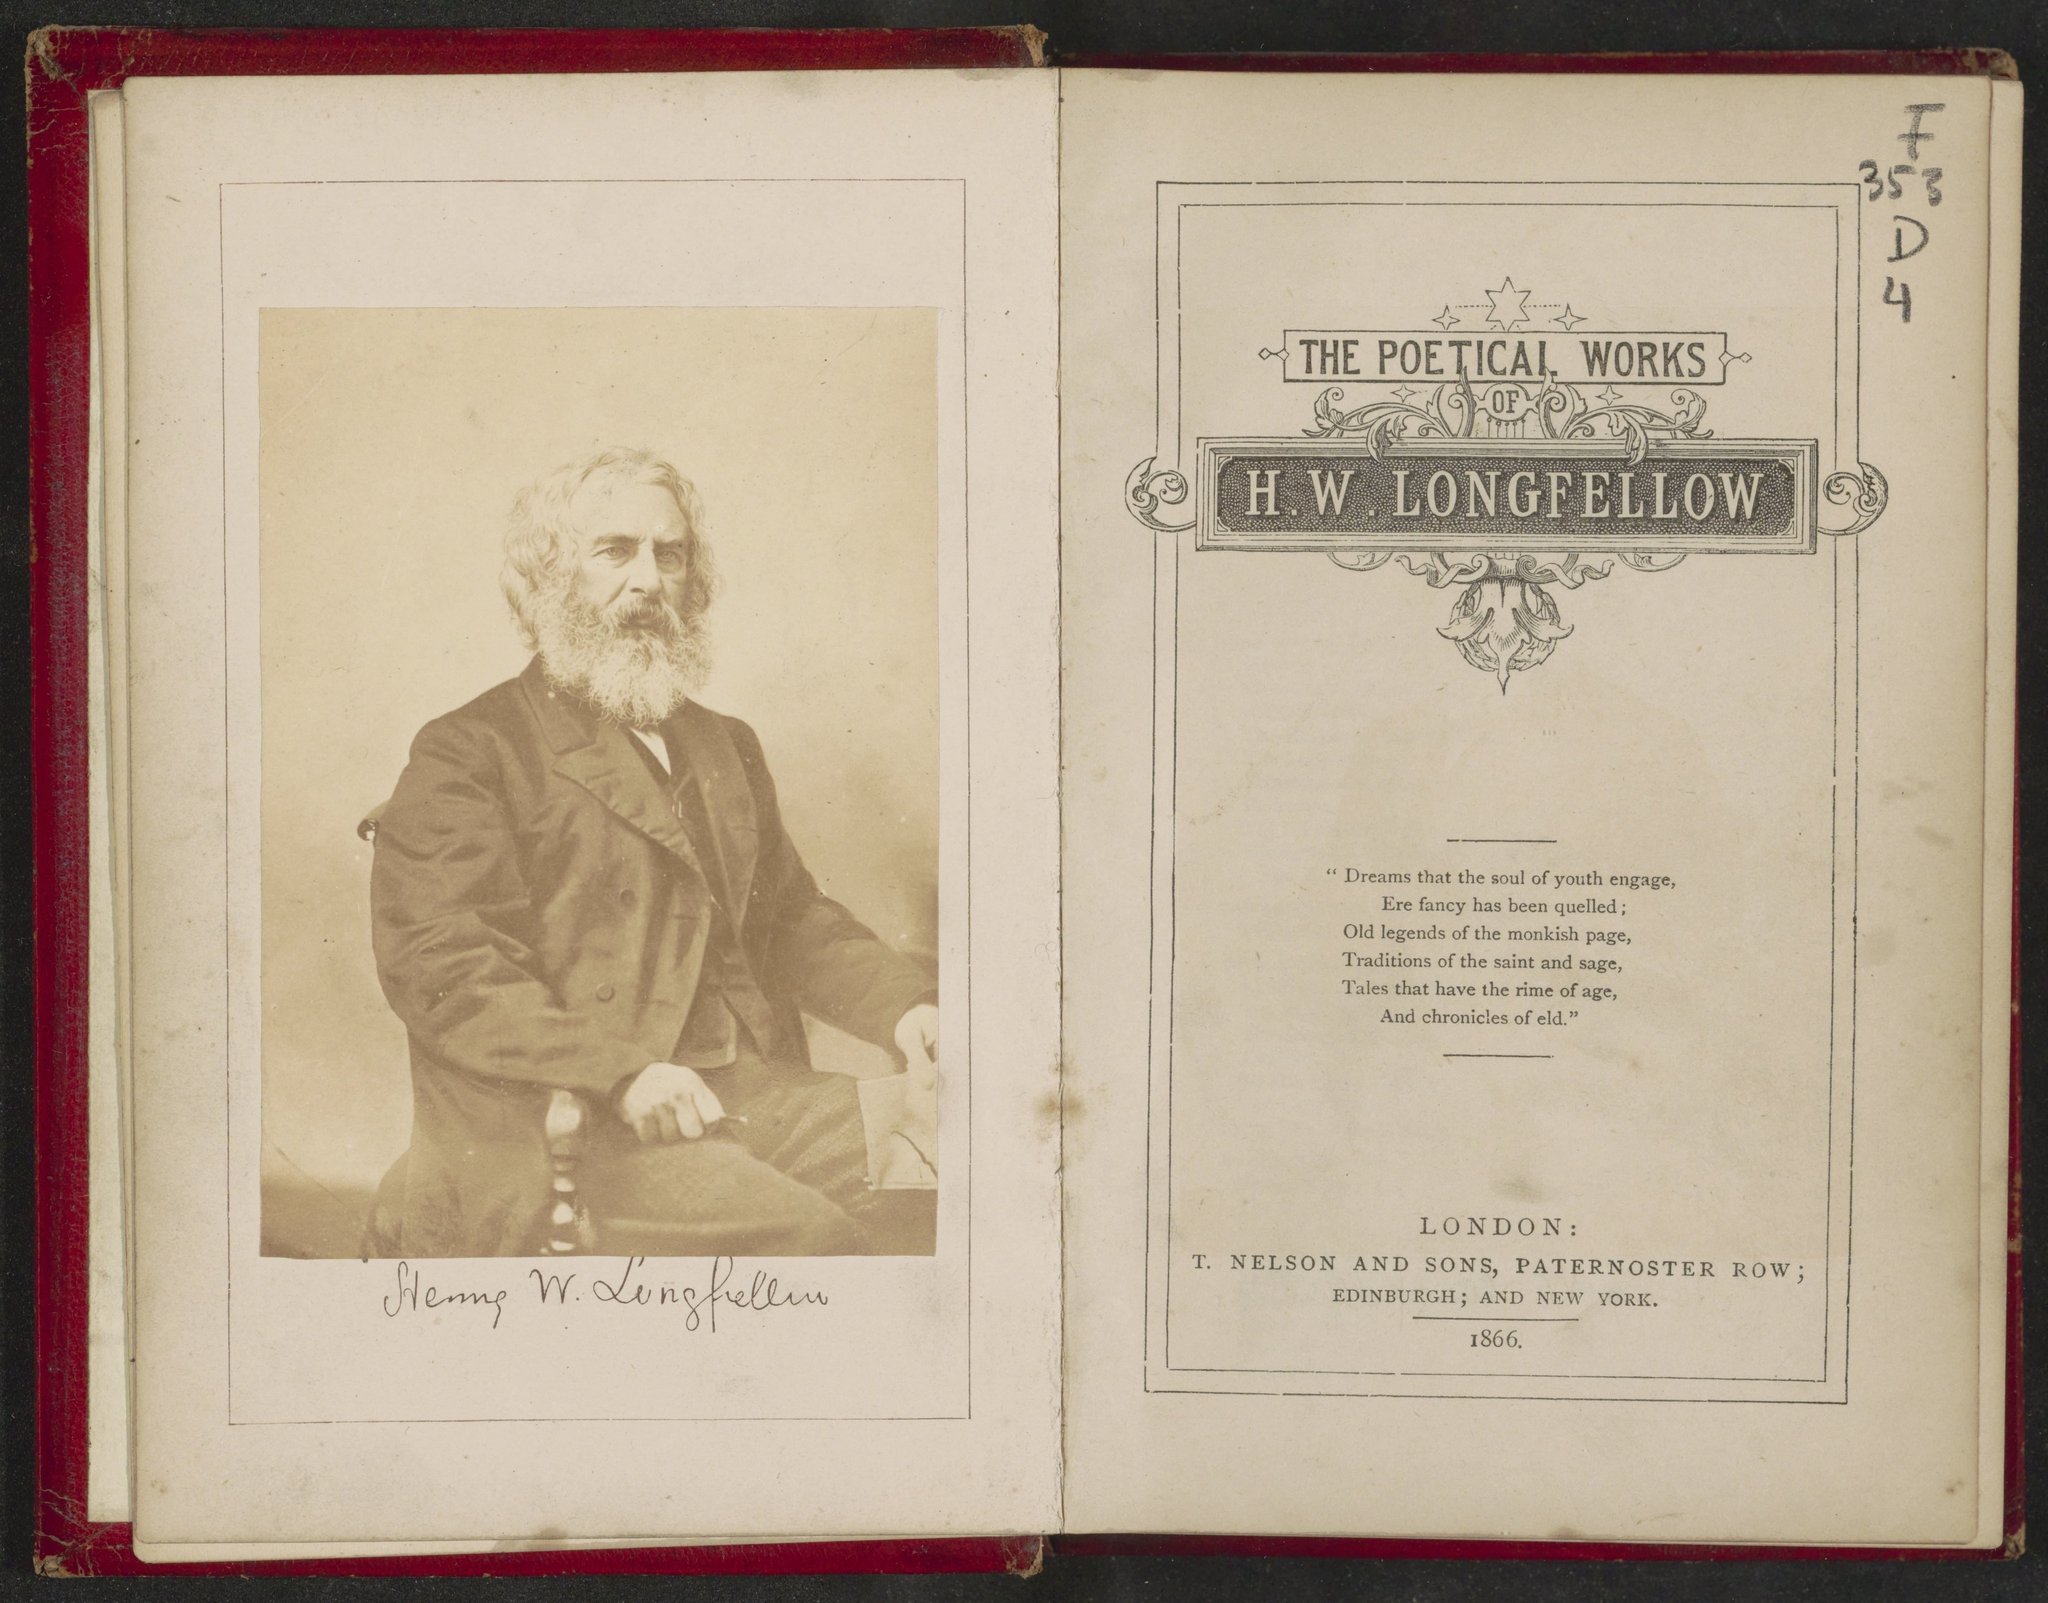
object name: photograph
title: Henry W. Longfellow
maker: Anonymous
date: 1856-1866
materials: photographic support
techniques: albumen print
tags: henry wadsworth longfellow, portrait, self-portrait of artist